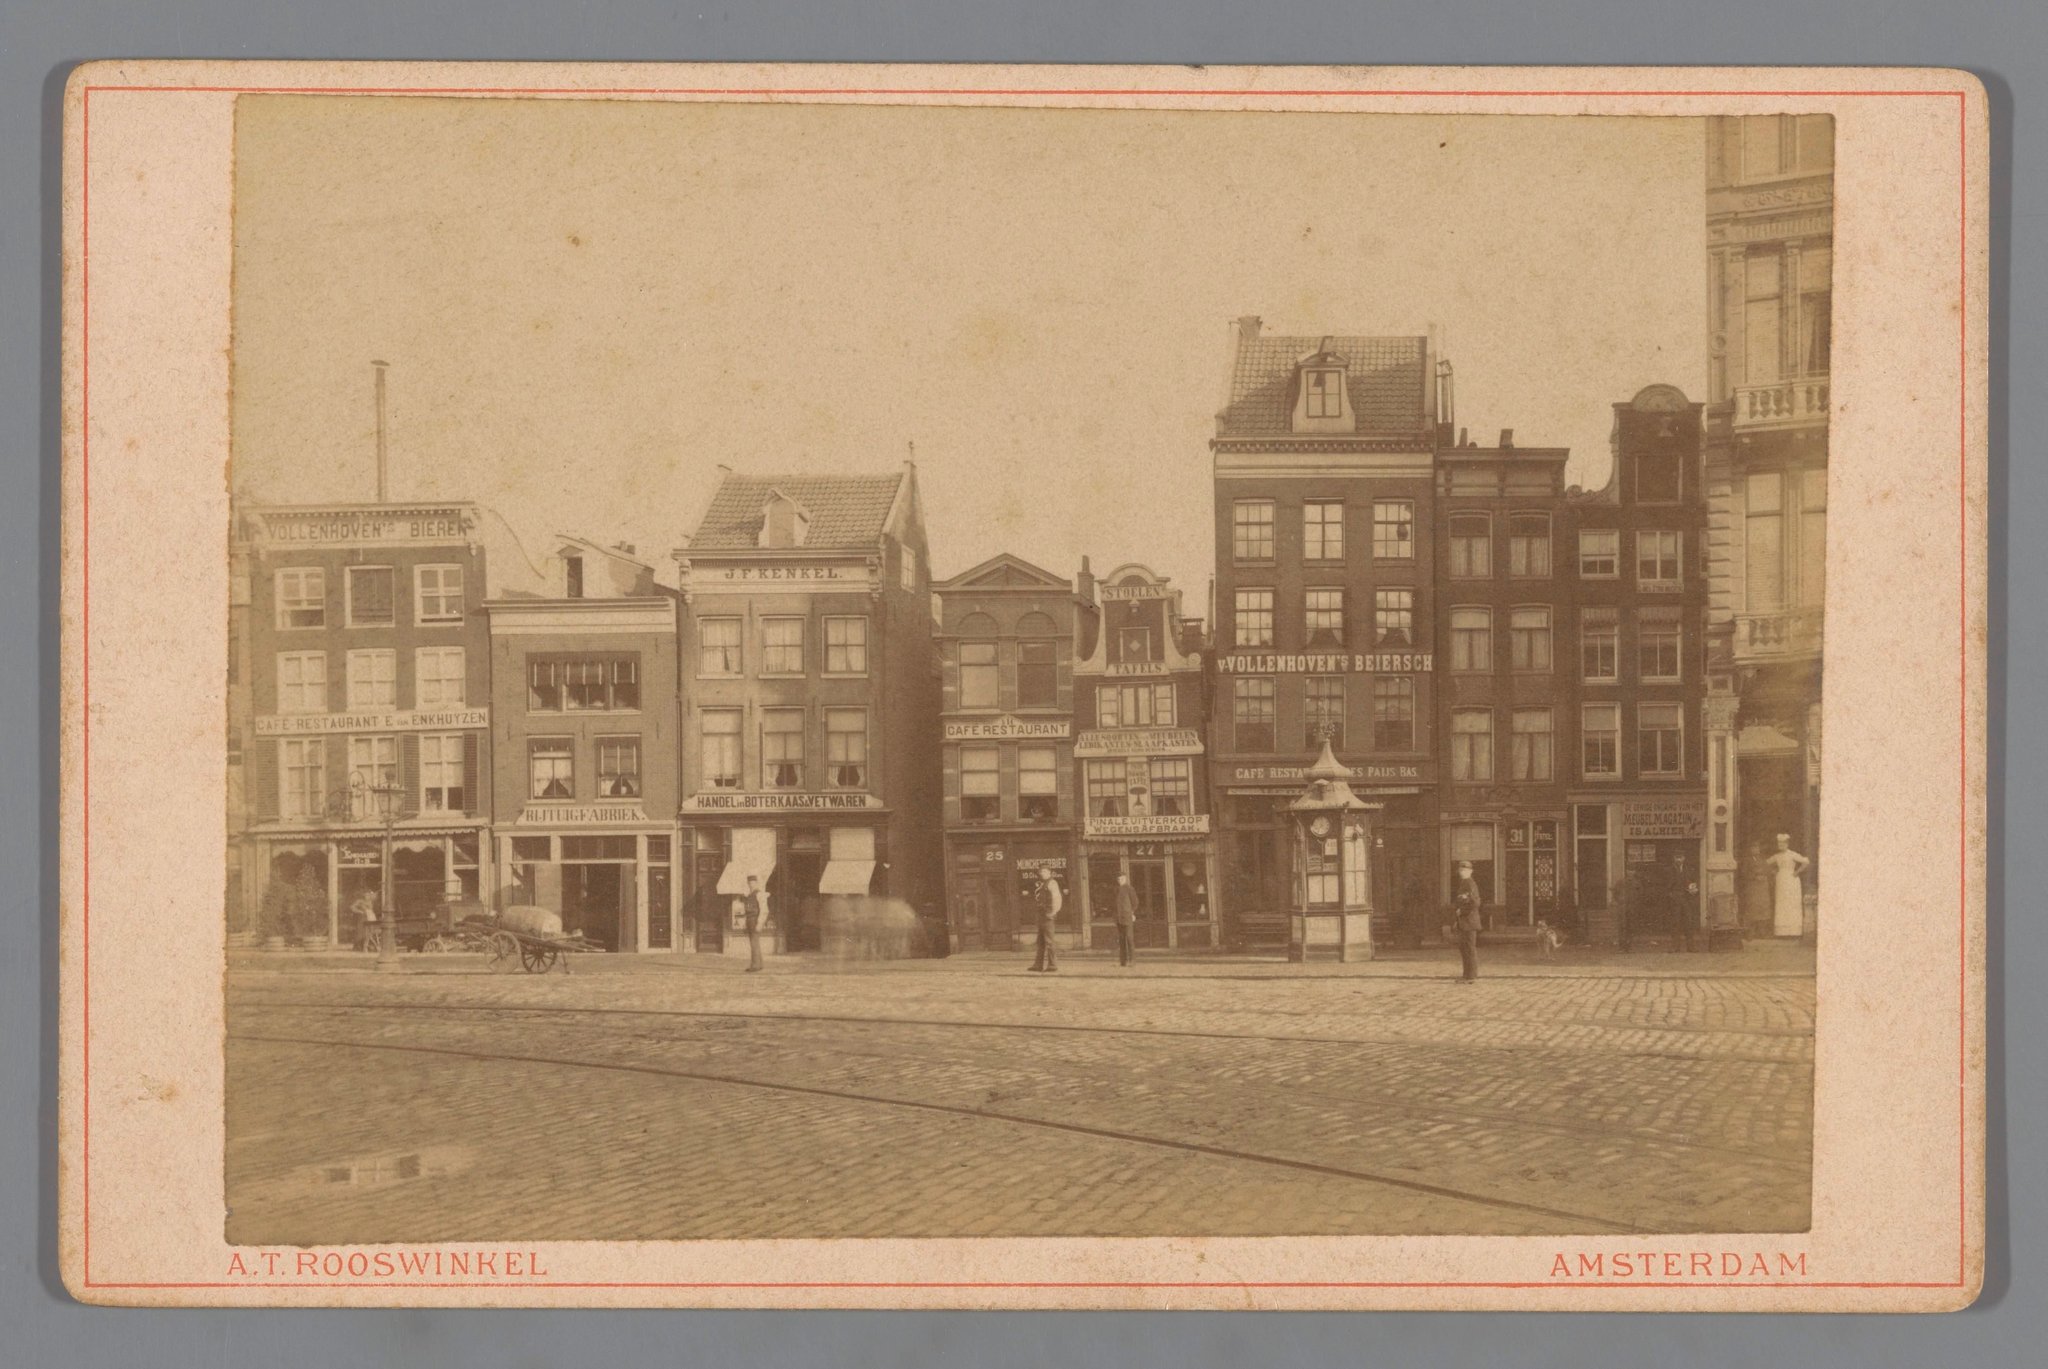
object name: cabinet photograph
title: Gezicht op het Rembrandtplein in Amsterdam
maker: andreas theodorus rooswinkel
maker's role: fotograaf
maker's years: 1838-1909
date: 1868-1875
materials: cardboard, photographic support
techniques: albumen print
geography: amsterdam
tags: square, place, circus, etc.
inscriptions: annotation: ‘Rembrandtpl.’, retailer's mark: ‘GEBR. DOUWES./ ATELIER/ Grimburgwal 15/ AMSTERDAM.’, annotation: ‘Rembrandtplein’